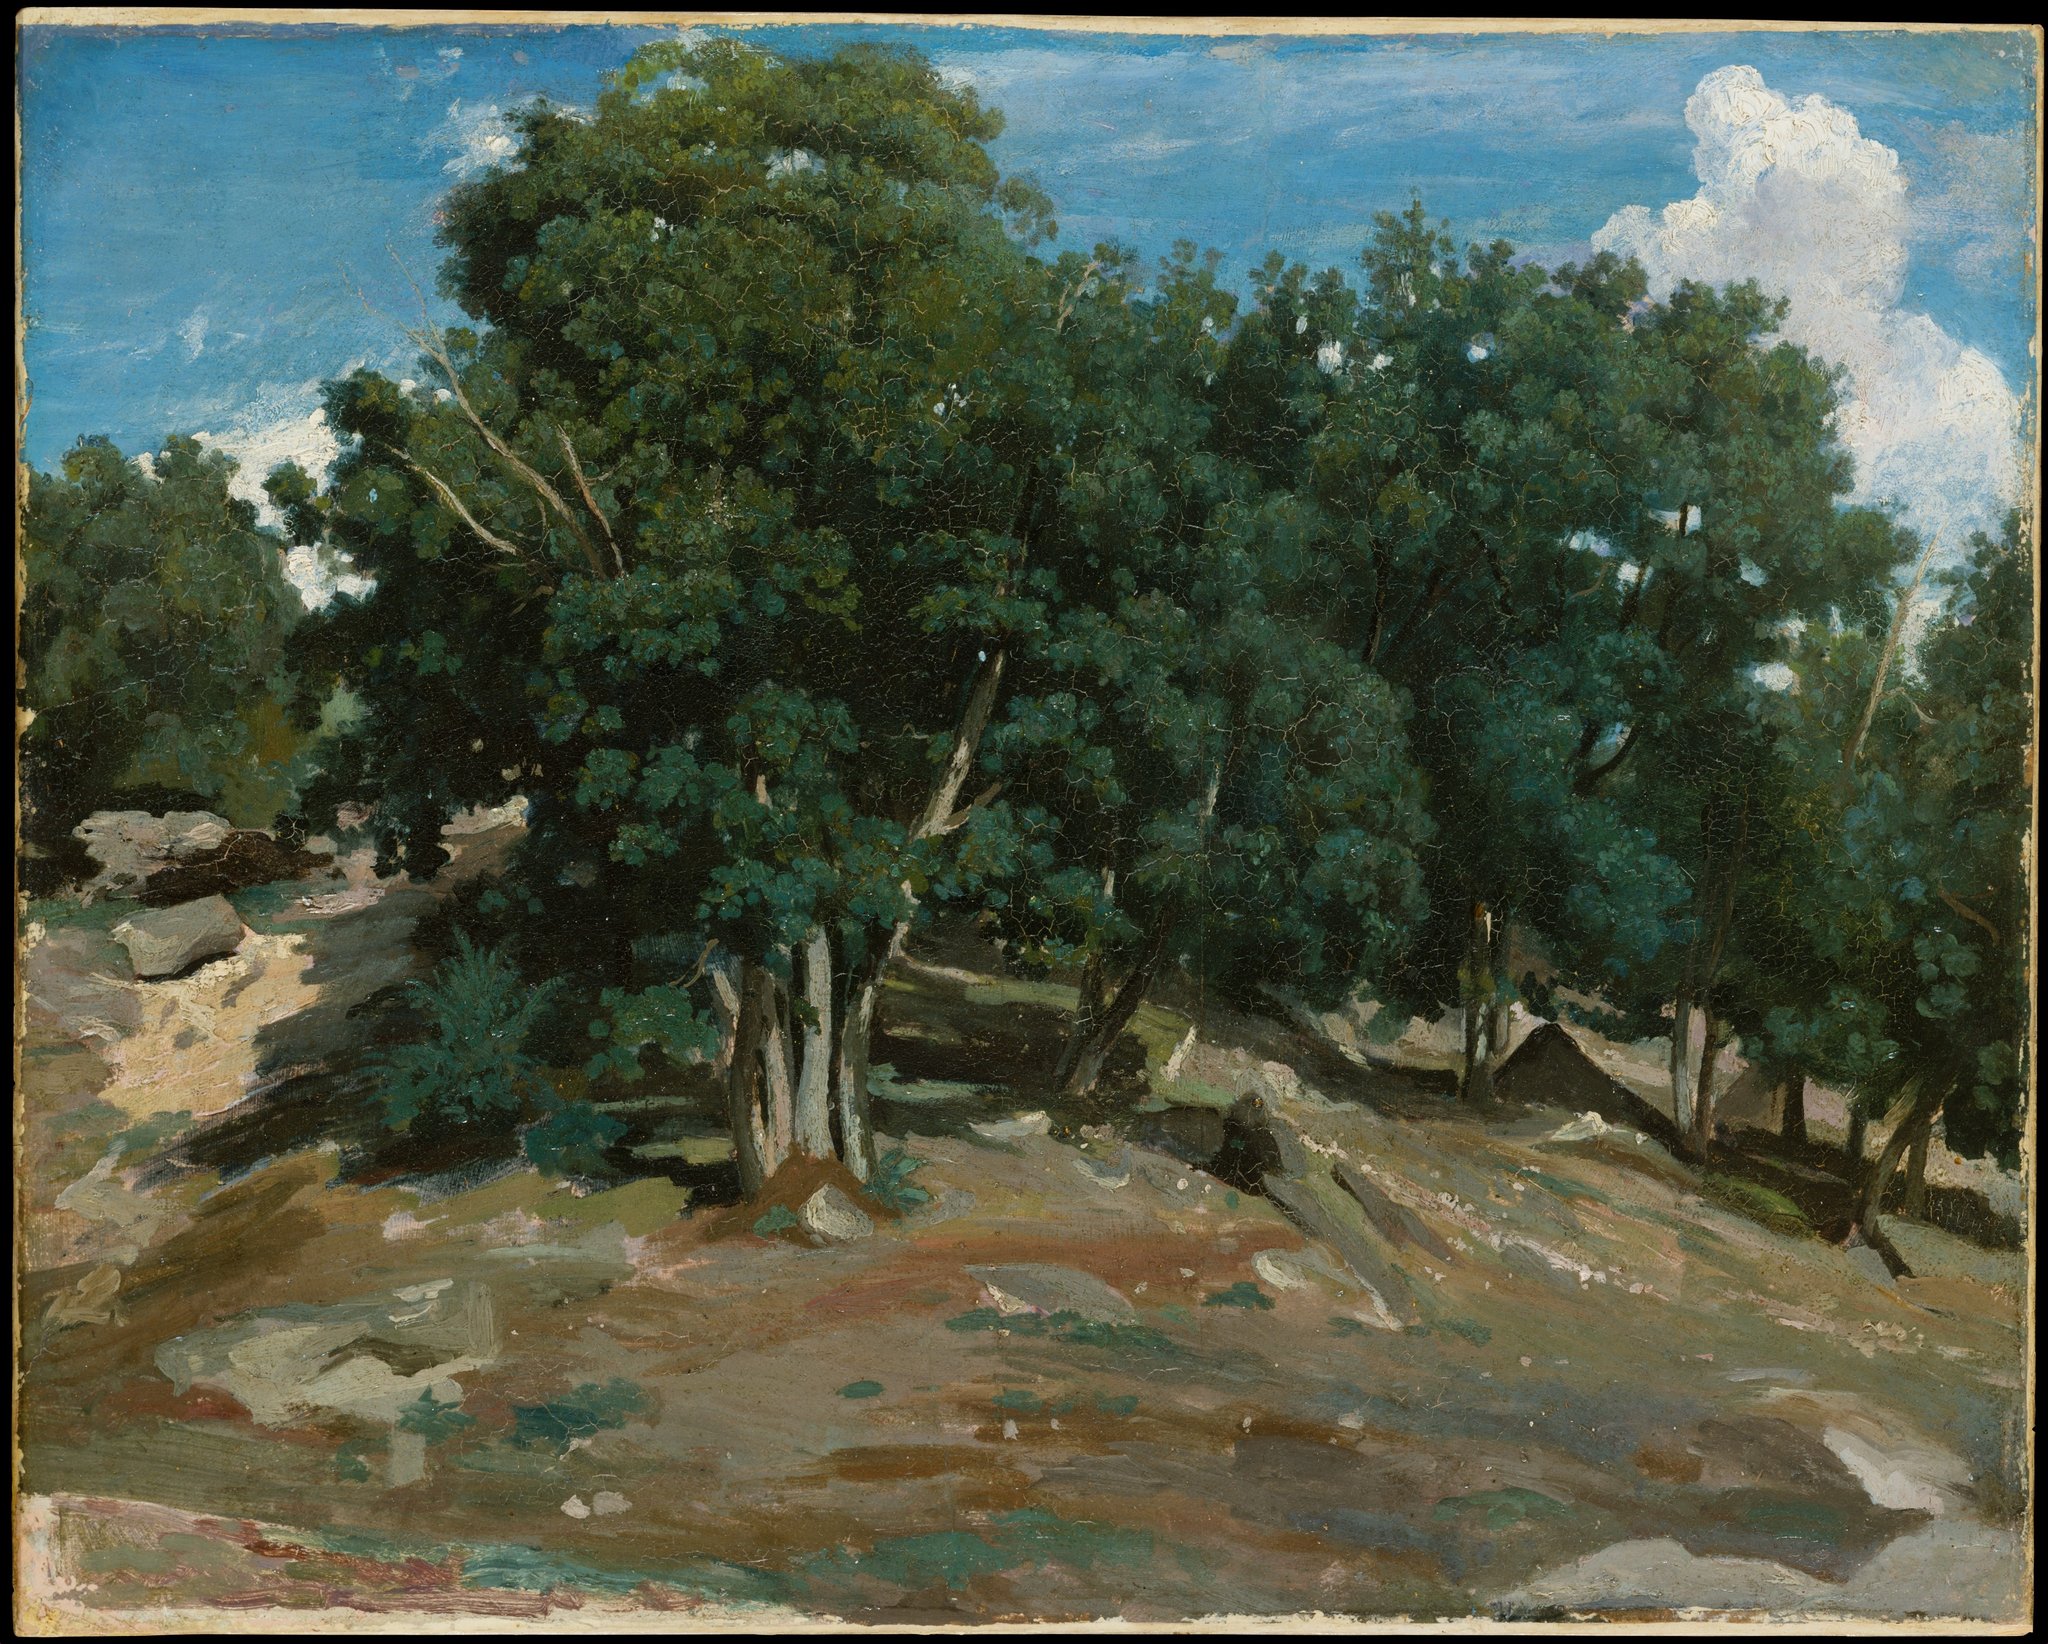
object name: drawing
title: Fontainebleau: Oak Trees at Bas-Bréau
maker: jean-baptiste-camille corot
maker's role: artist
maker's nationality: french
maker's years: 1796-1875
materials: oil, paper, wood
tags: forests,oaks